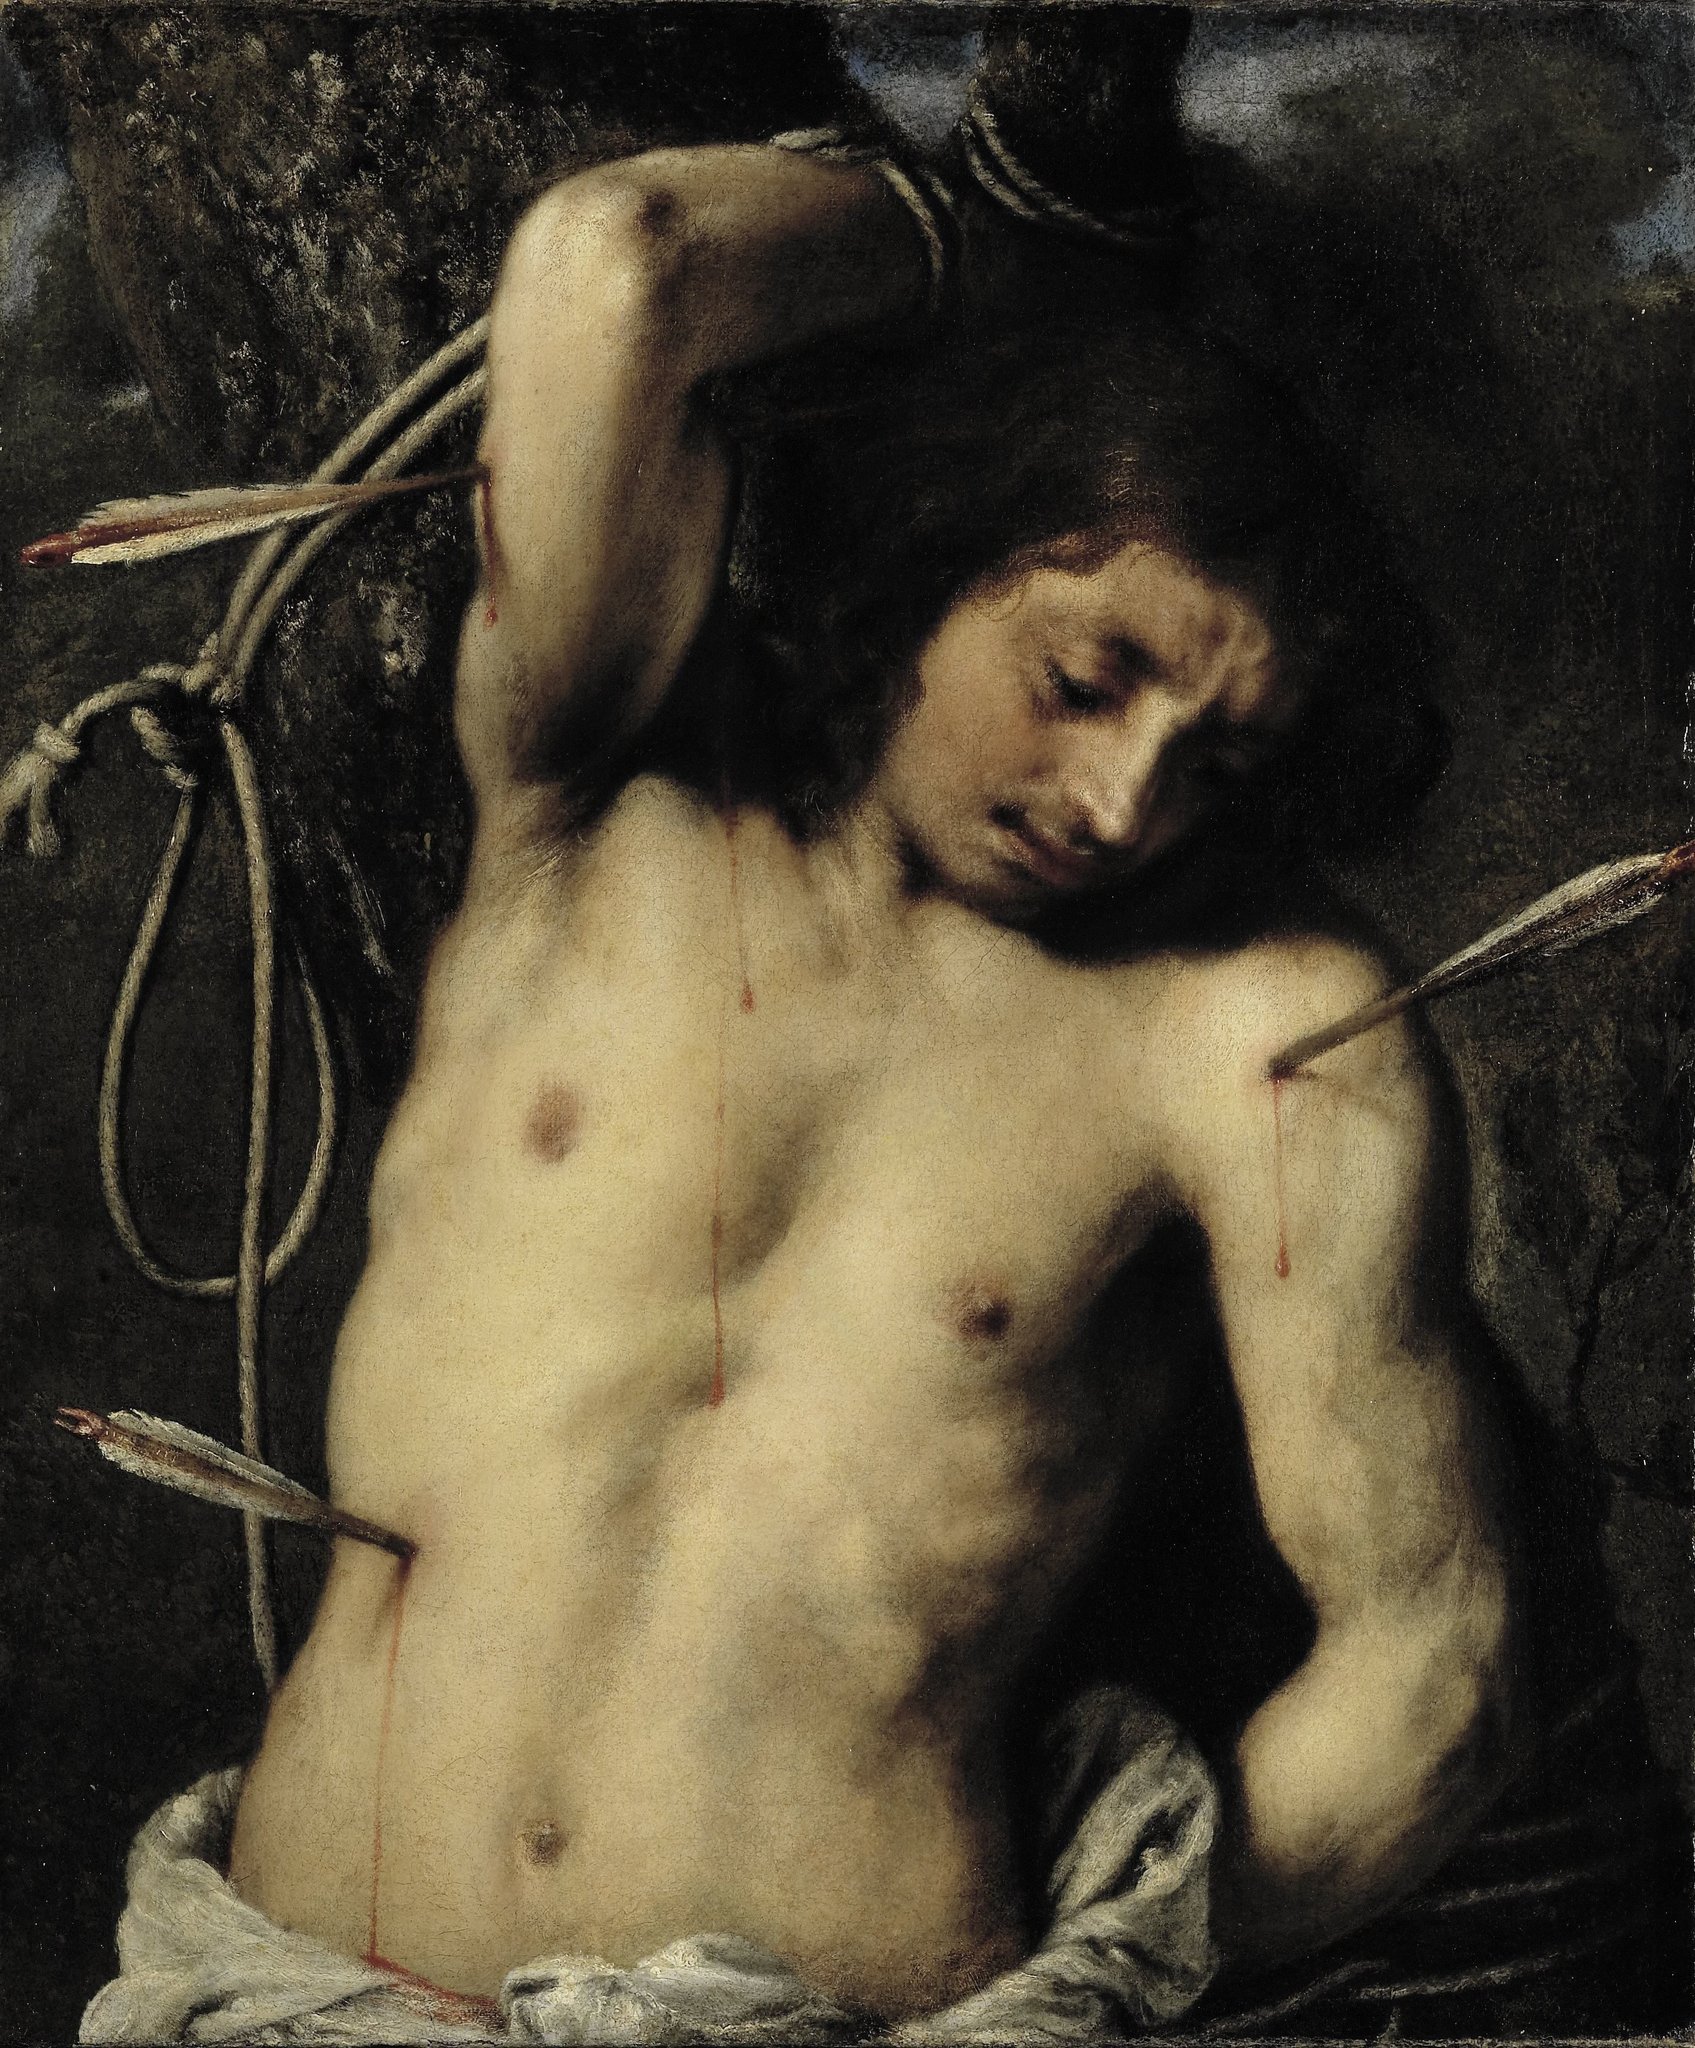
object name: painting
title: St Sebastian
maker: juan carreño de miranda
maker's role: painter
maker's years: 1614-1685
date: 1655-1665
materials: canvas, oil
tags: st. sebastian, tied to a tree or a pillar, is pierced by arrows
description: Attributed to Juan Carreño de Miranda (1614 - 1685). The Holy Sebastian. Presented by A. Willet, 1887.